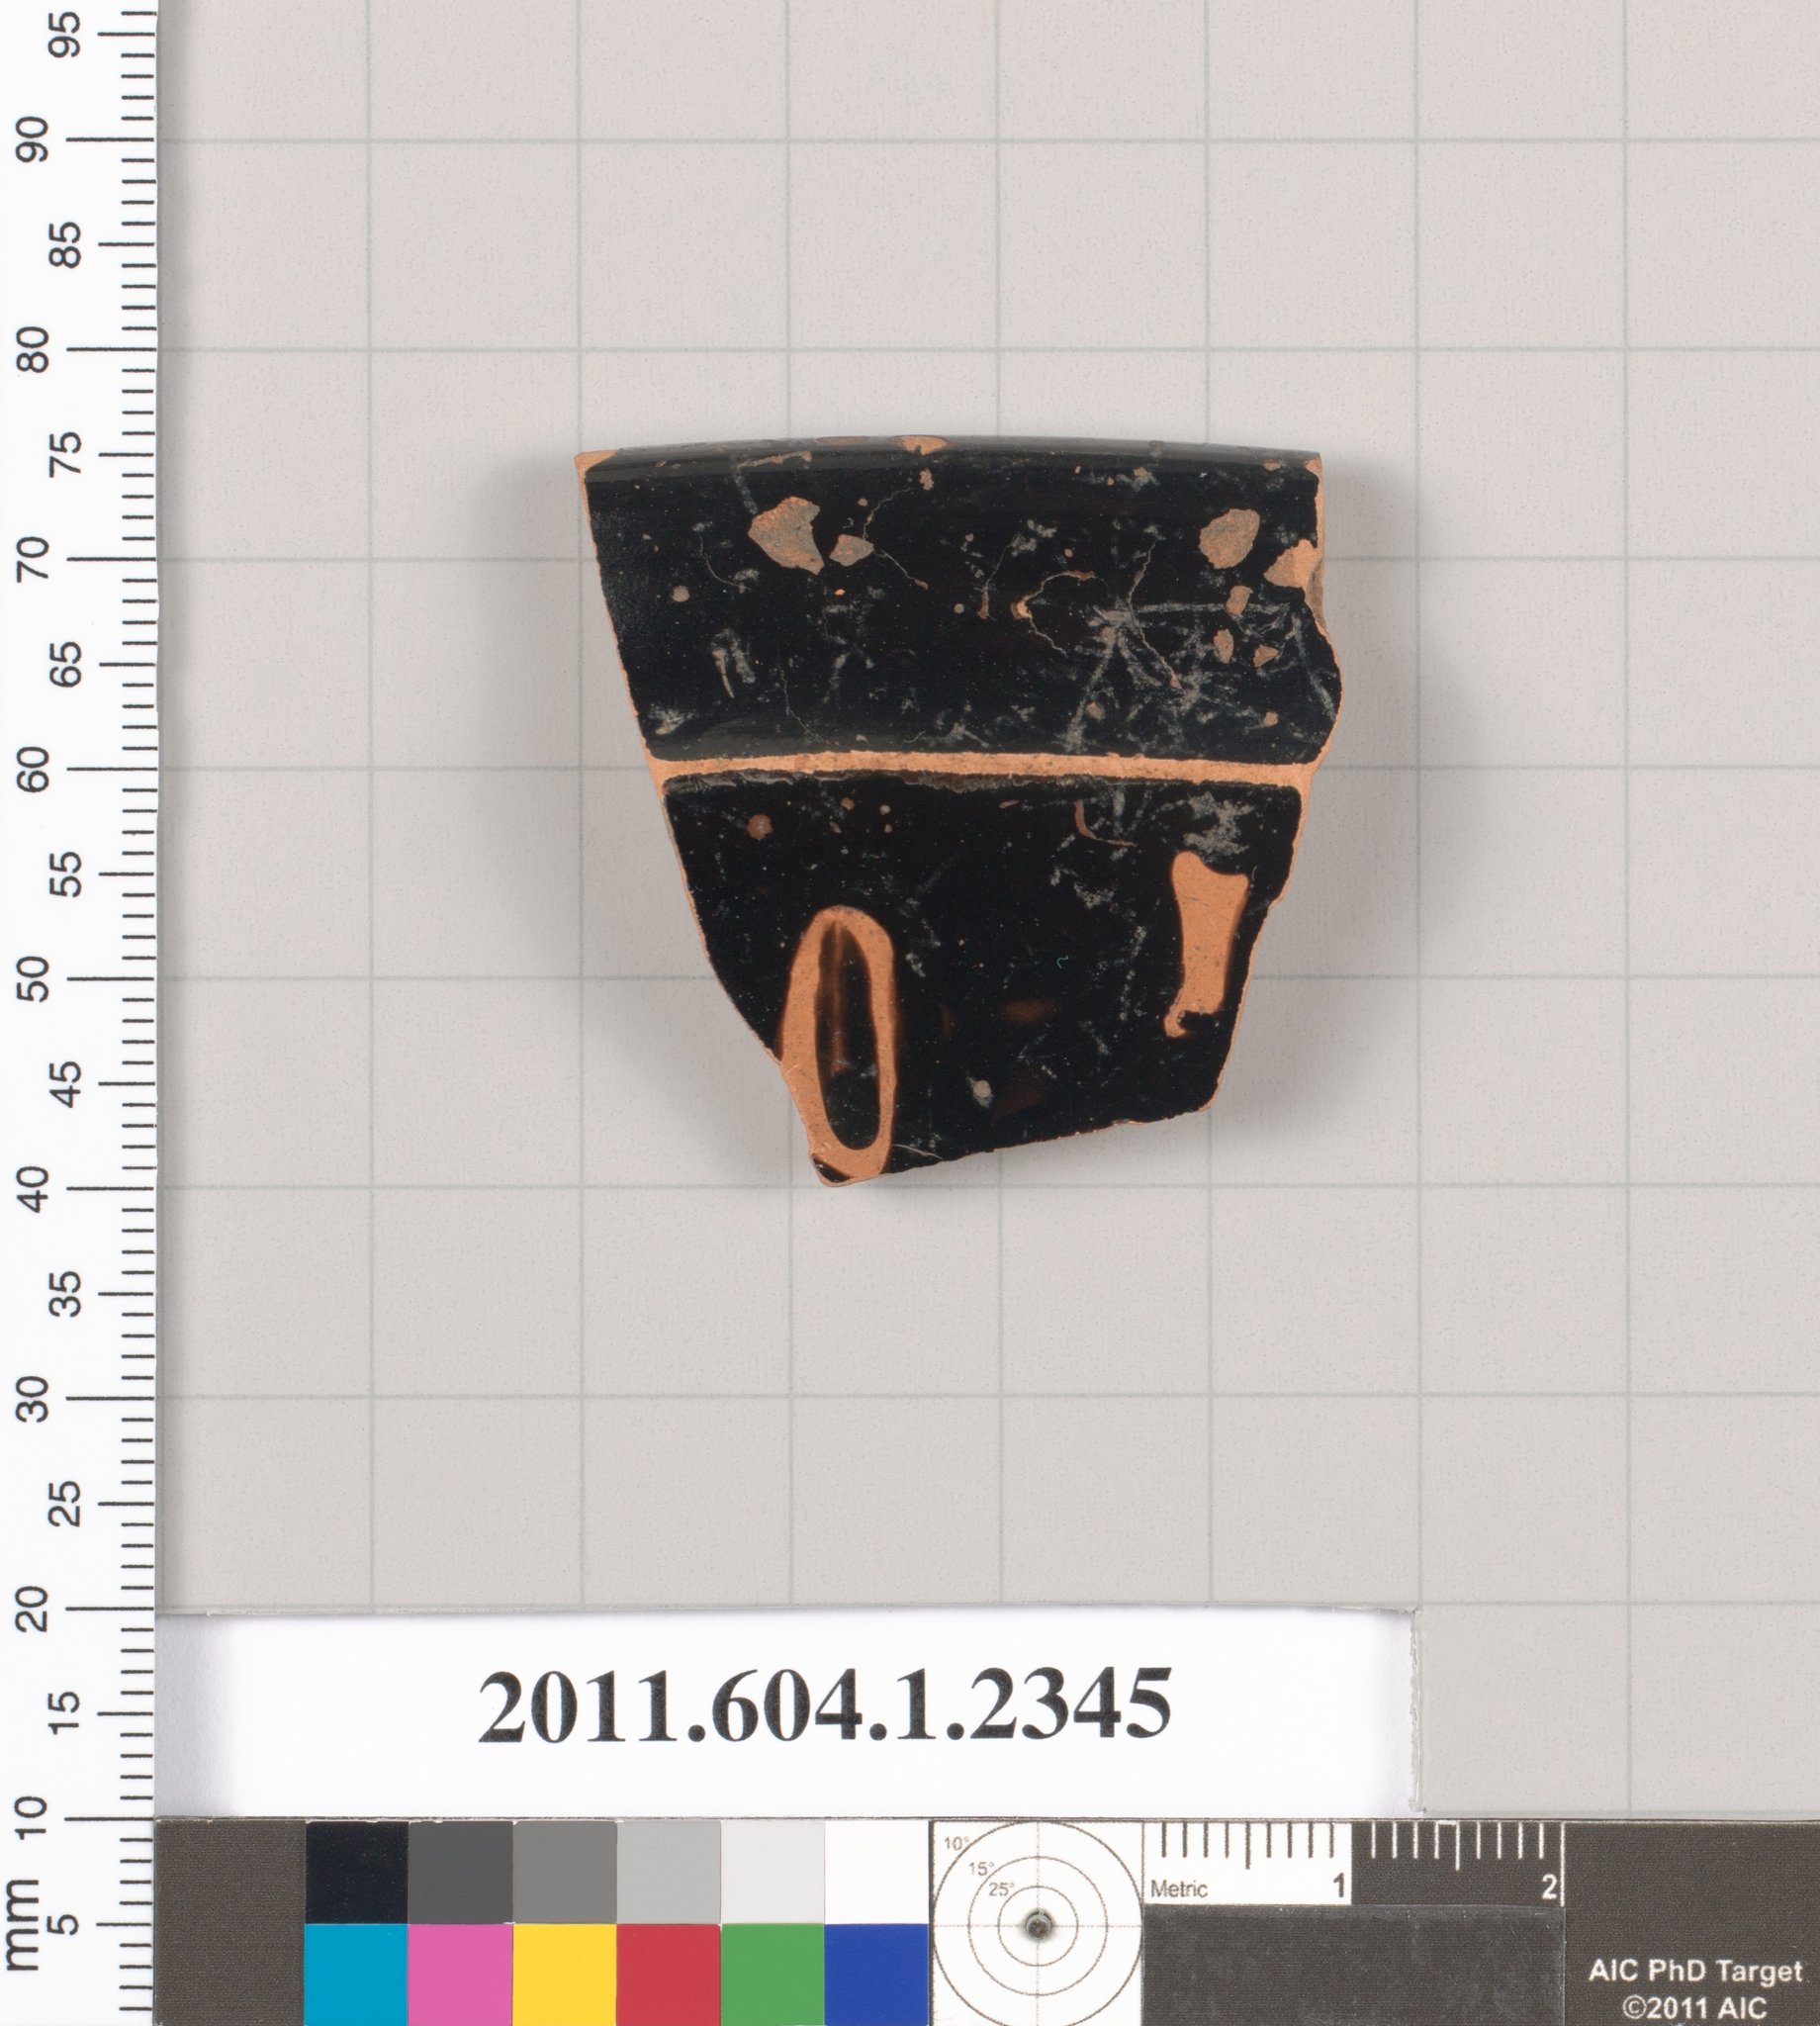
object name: kylix fragment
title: Terracotta rim fragment of a kylix (drinking cup)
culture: greek, attic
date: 467-435 BCE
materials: terracotta